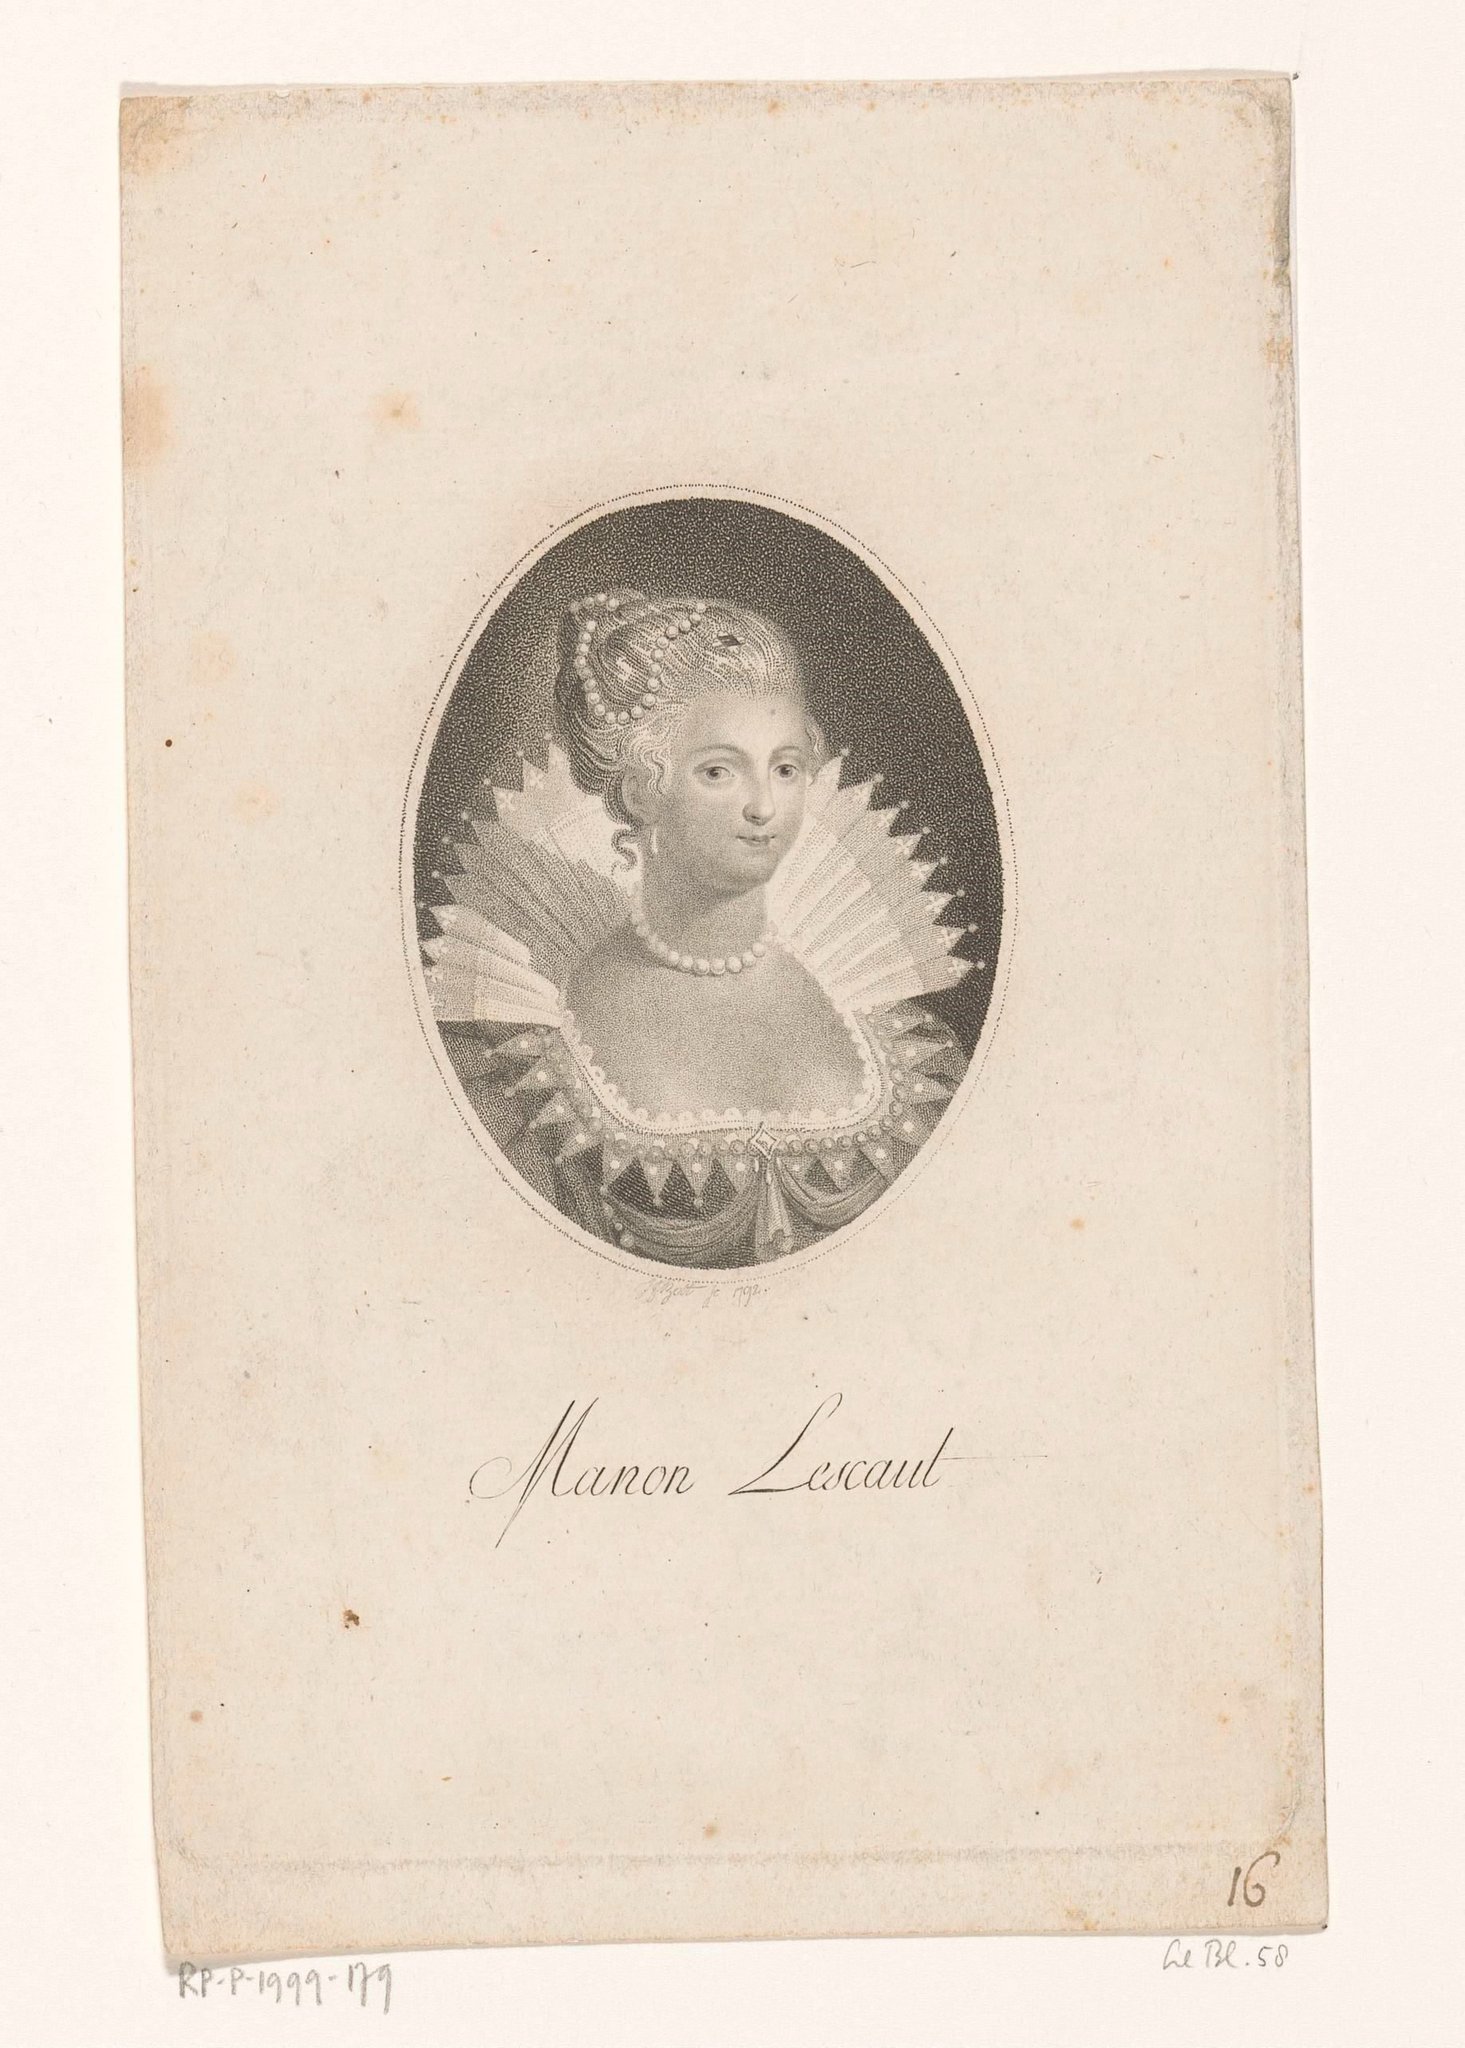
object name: print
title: Portret van Manon Lescaut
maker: johann friedrich bolt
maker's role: print maker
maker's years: 1769-1836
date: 1792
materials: paper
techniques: stippling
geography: berlin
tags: female literary characters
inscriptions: collector's mark: Lugt 2228, collector's mark: Lugt 2760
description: Manon Lescaut is een literair figuur uit een van de verhalen van Antoine François Prévost.